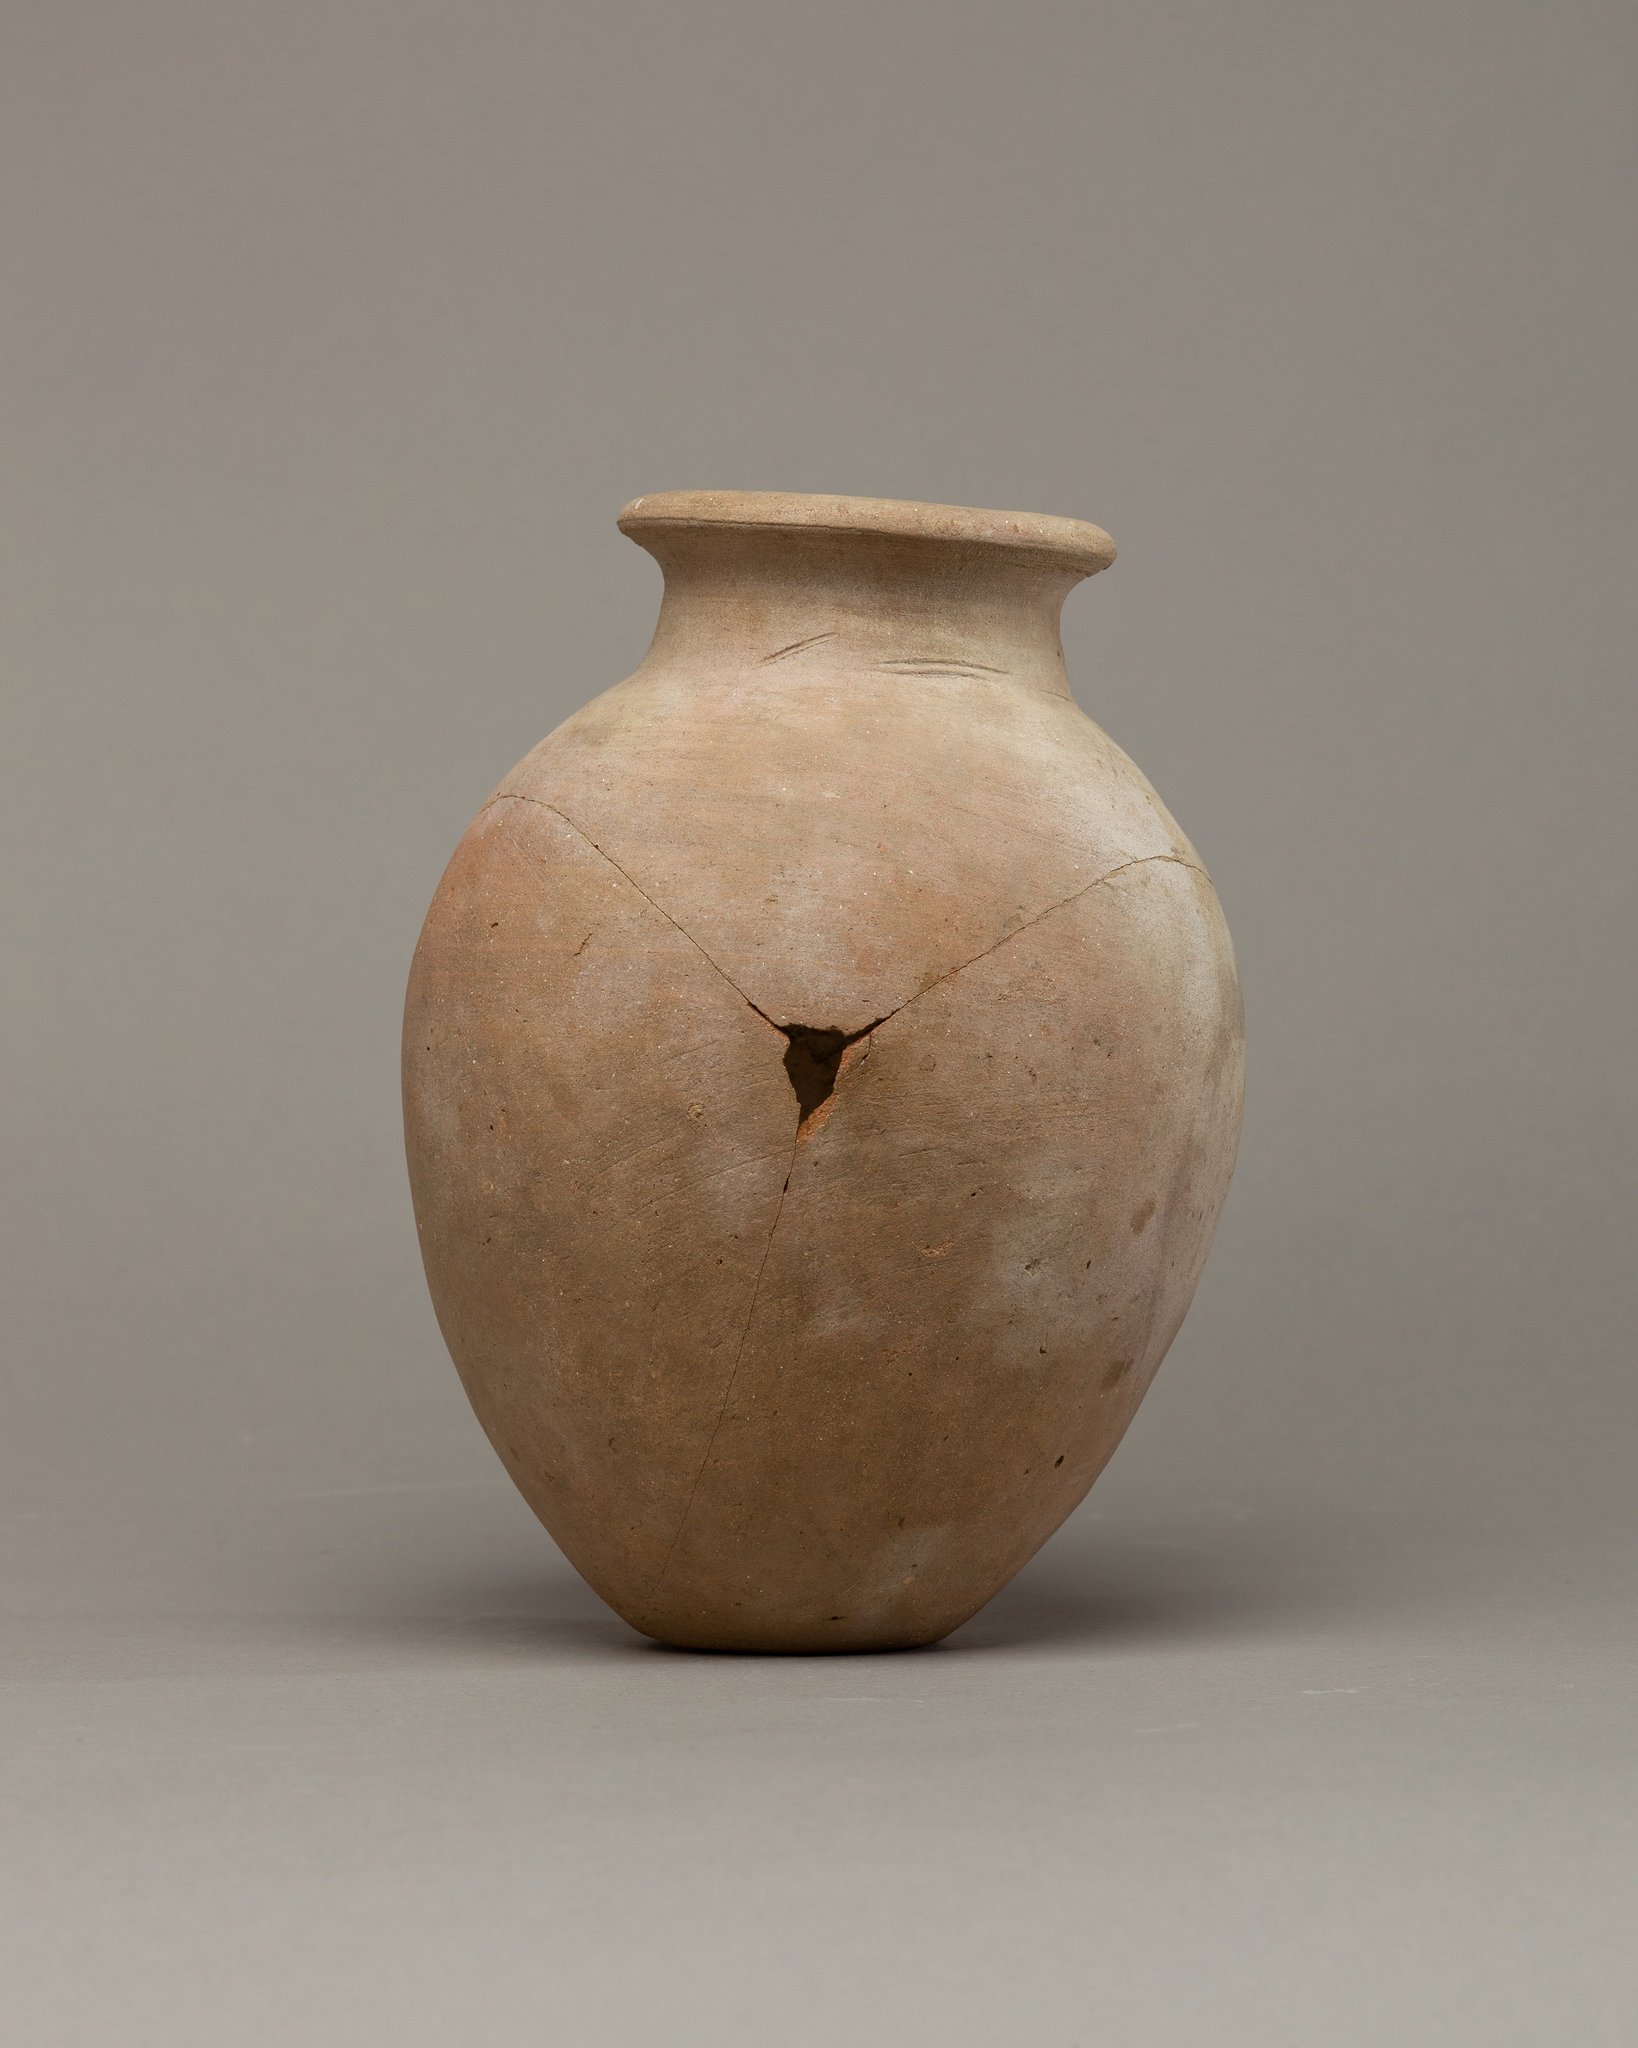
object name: jar, shouldered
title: High-shouldered jar of desert clay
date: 3850-2960 BCE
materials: pottery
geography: egypt